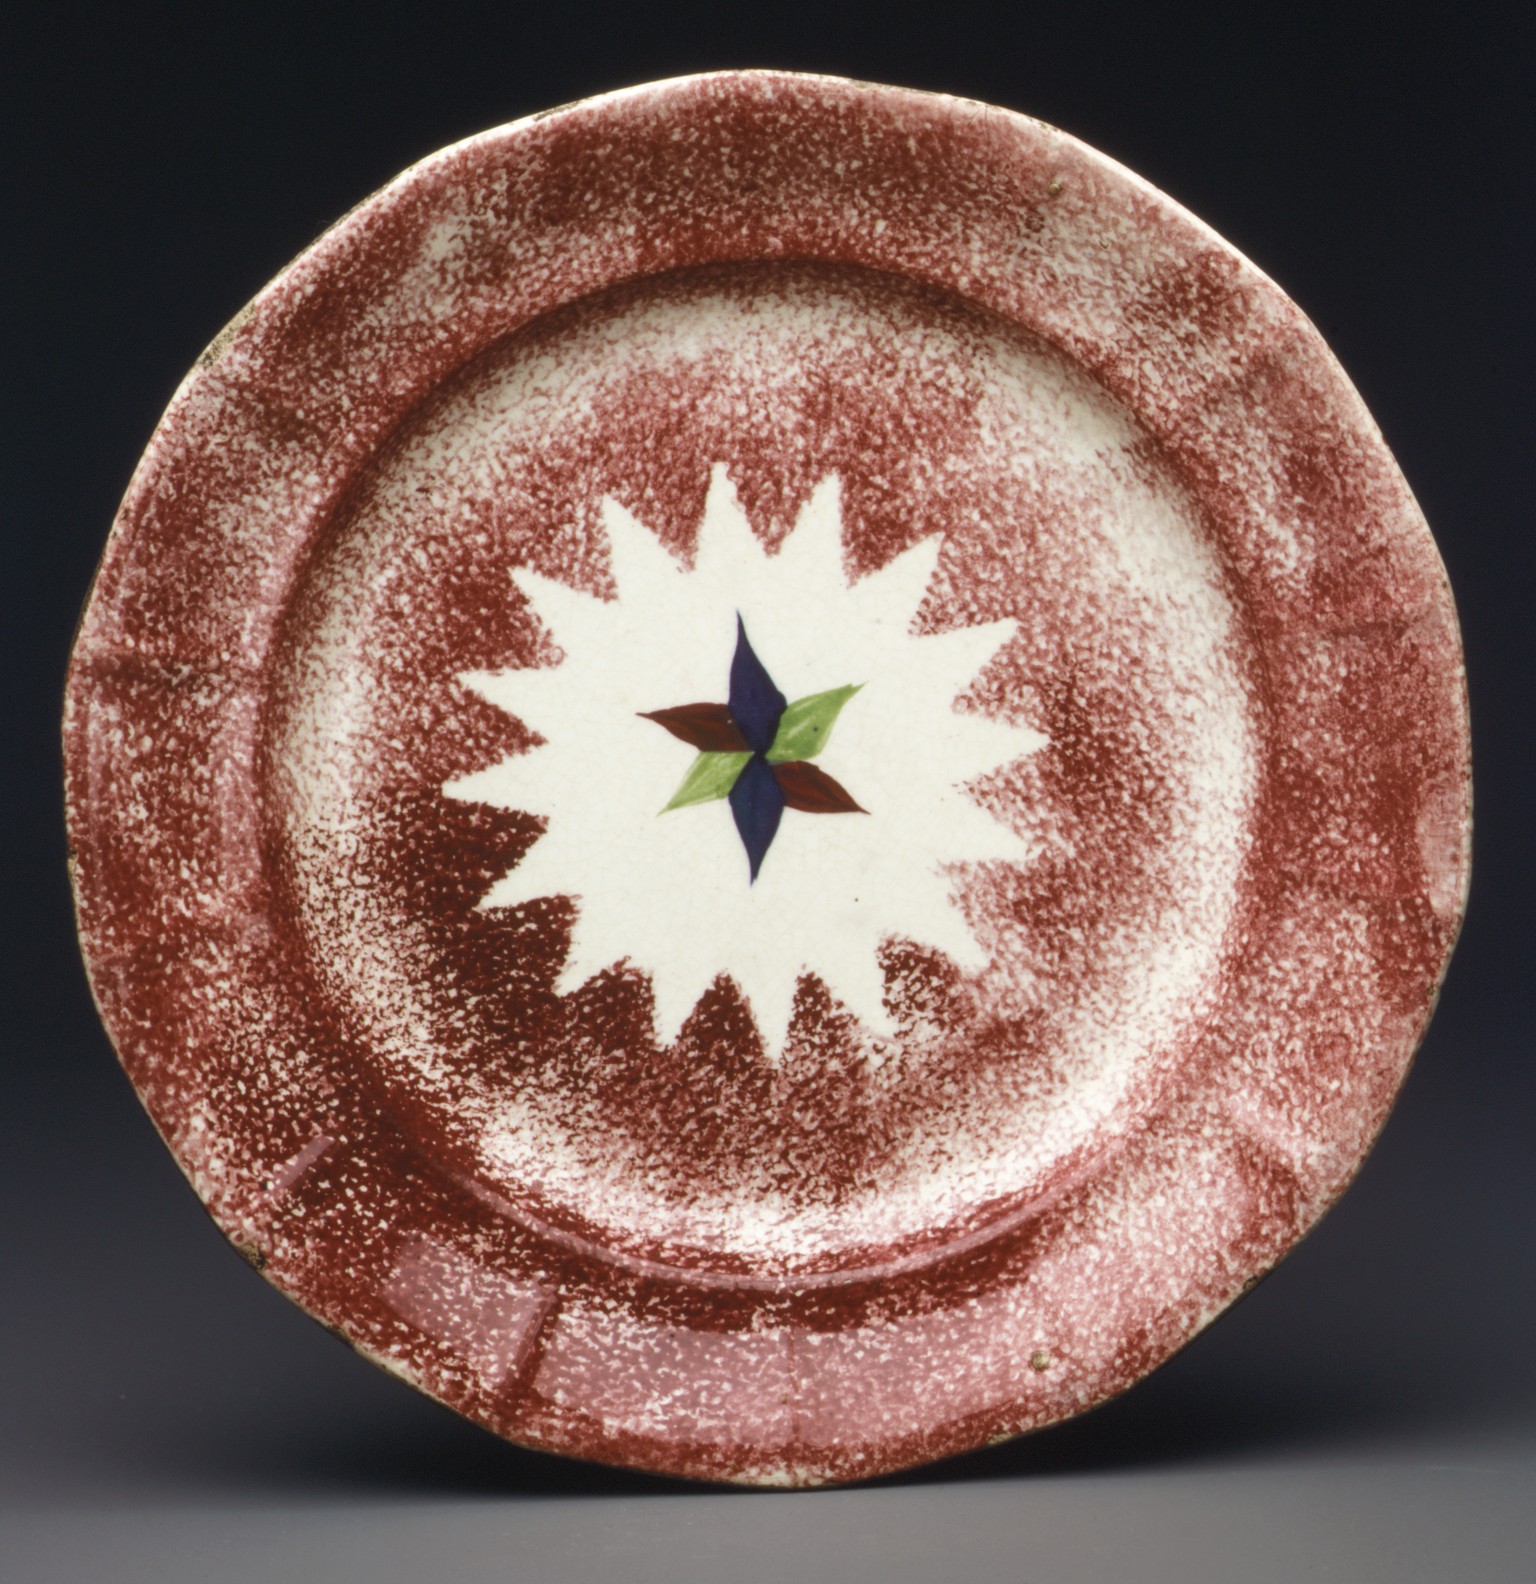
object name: plate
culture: british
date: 1800-1830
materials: earthenware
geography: england